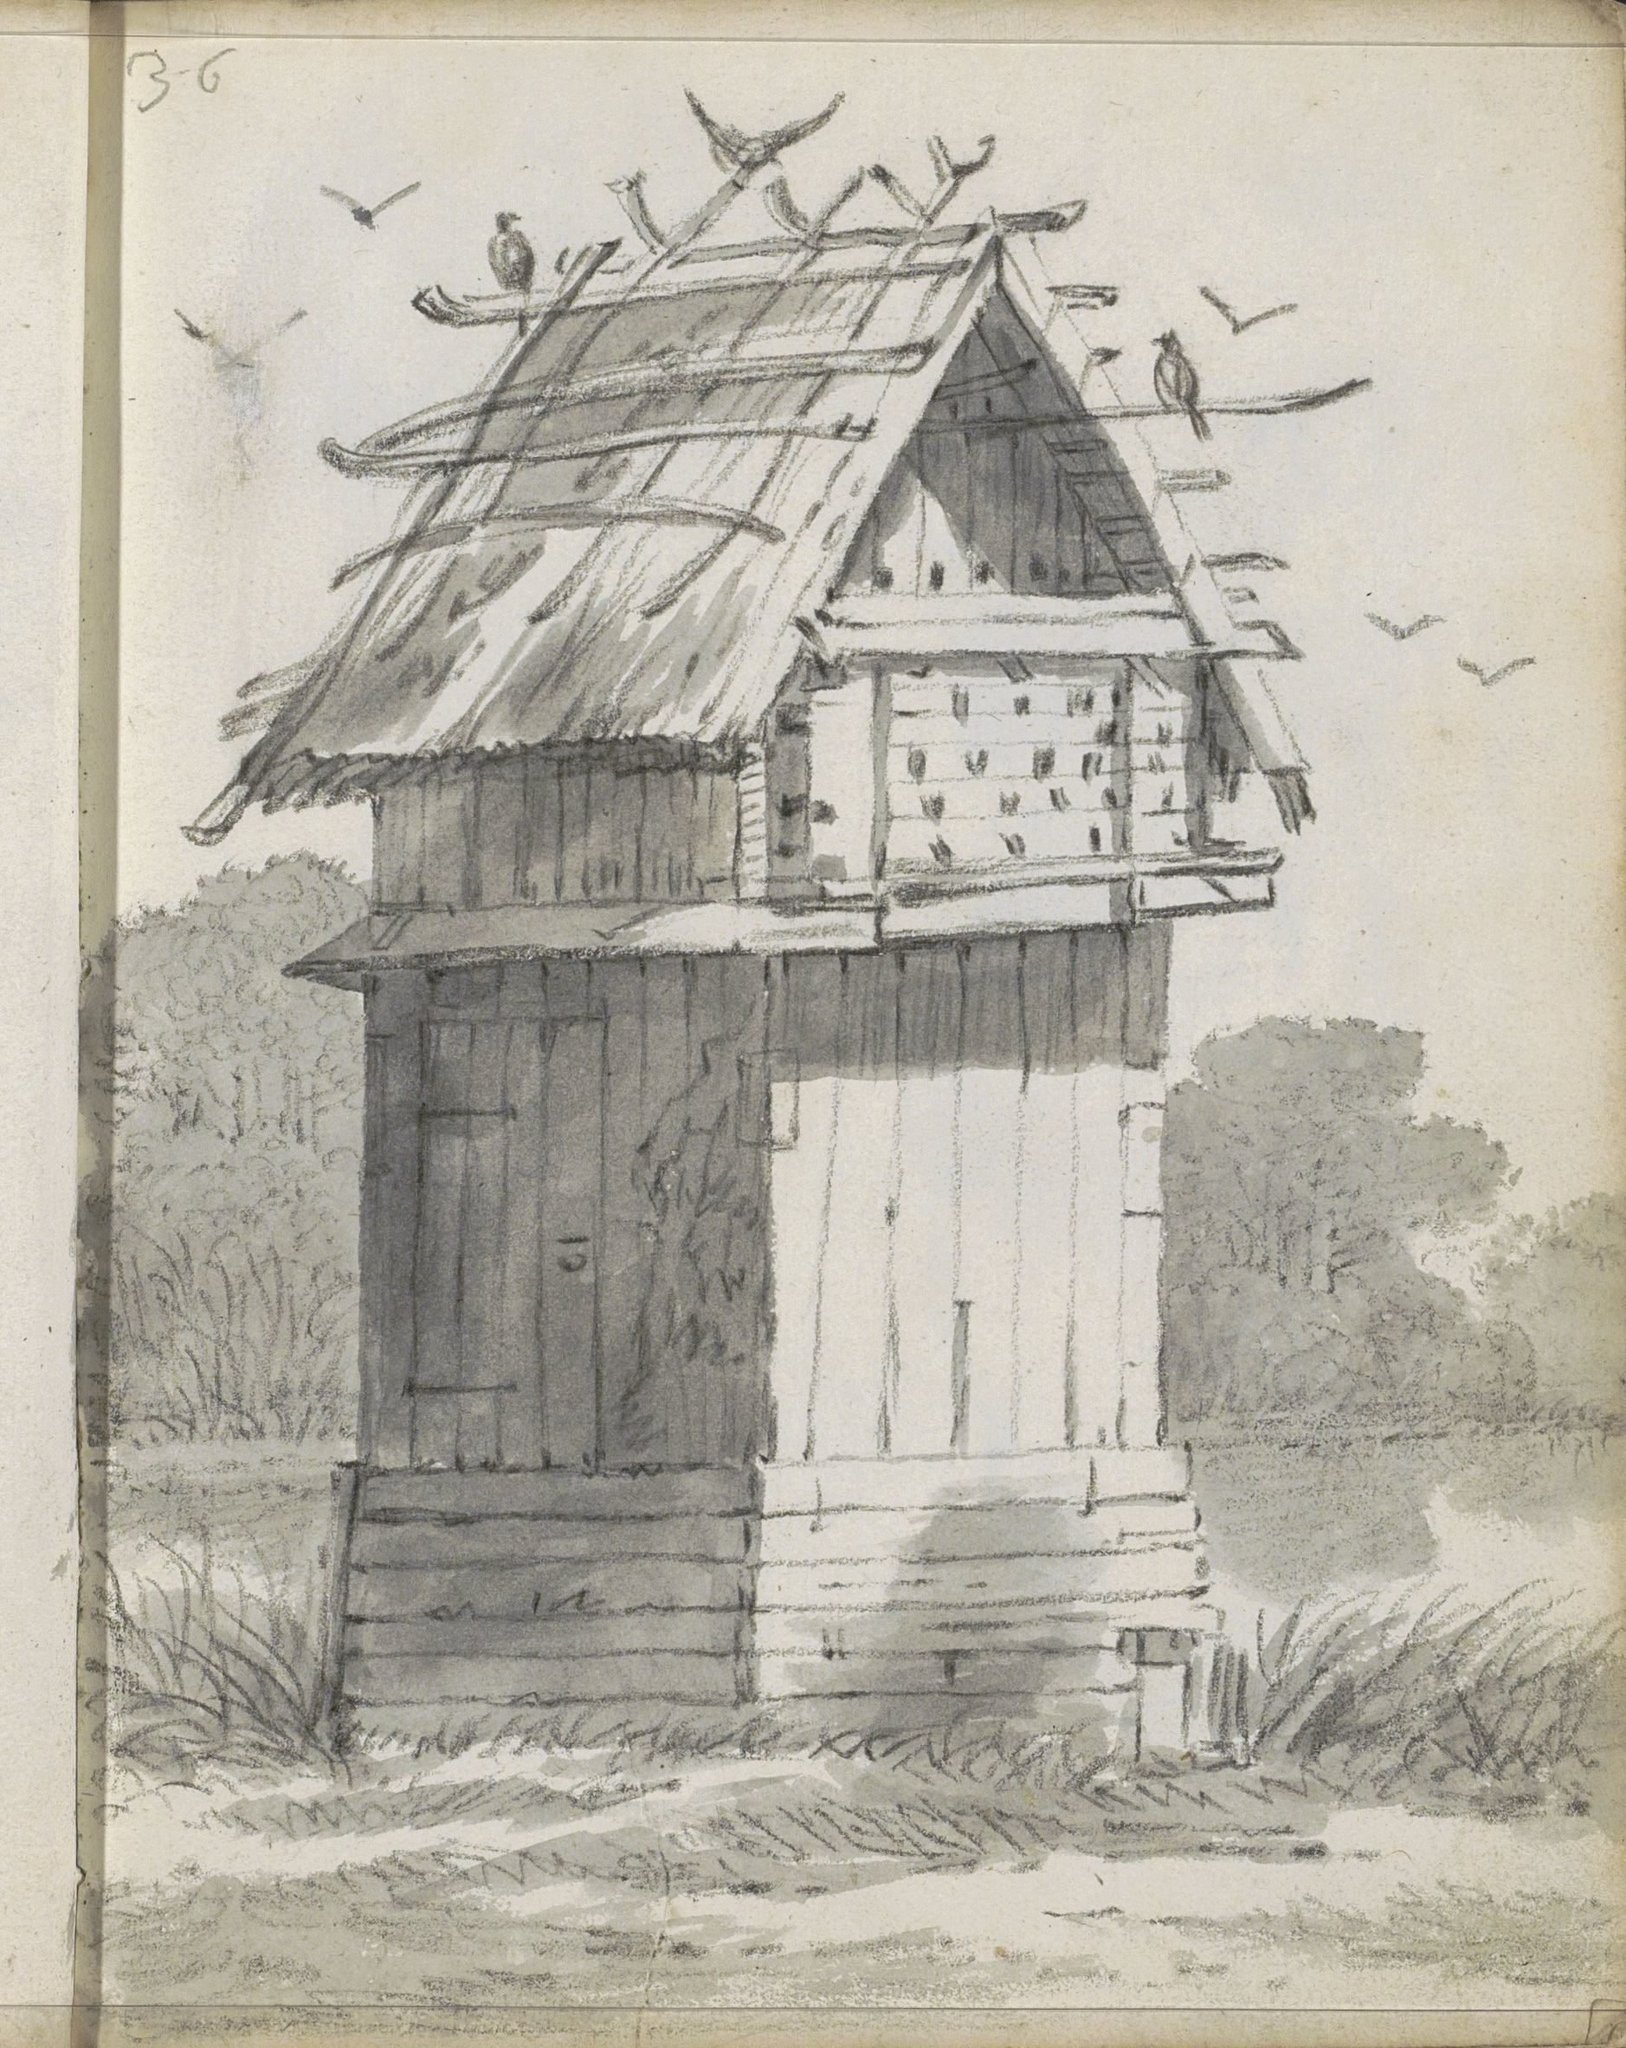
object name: sketchbook leaf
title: Duiventil in een landschap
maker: cornelis saftleven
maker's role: draughtsman, painter, print maker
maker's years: 1607-1681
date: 1666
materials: chalk, ink, paper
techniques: brush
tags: landscapes with waters, waterscapes, seascapes (in the temperate zone), dove-cote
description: Blad 36 recto uit een schetsboek met 49 bladen.